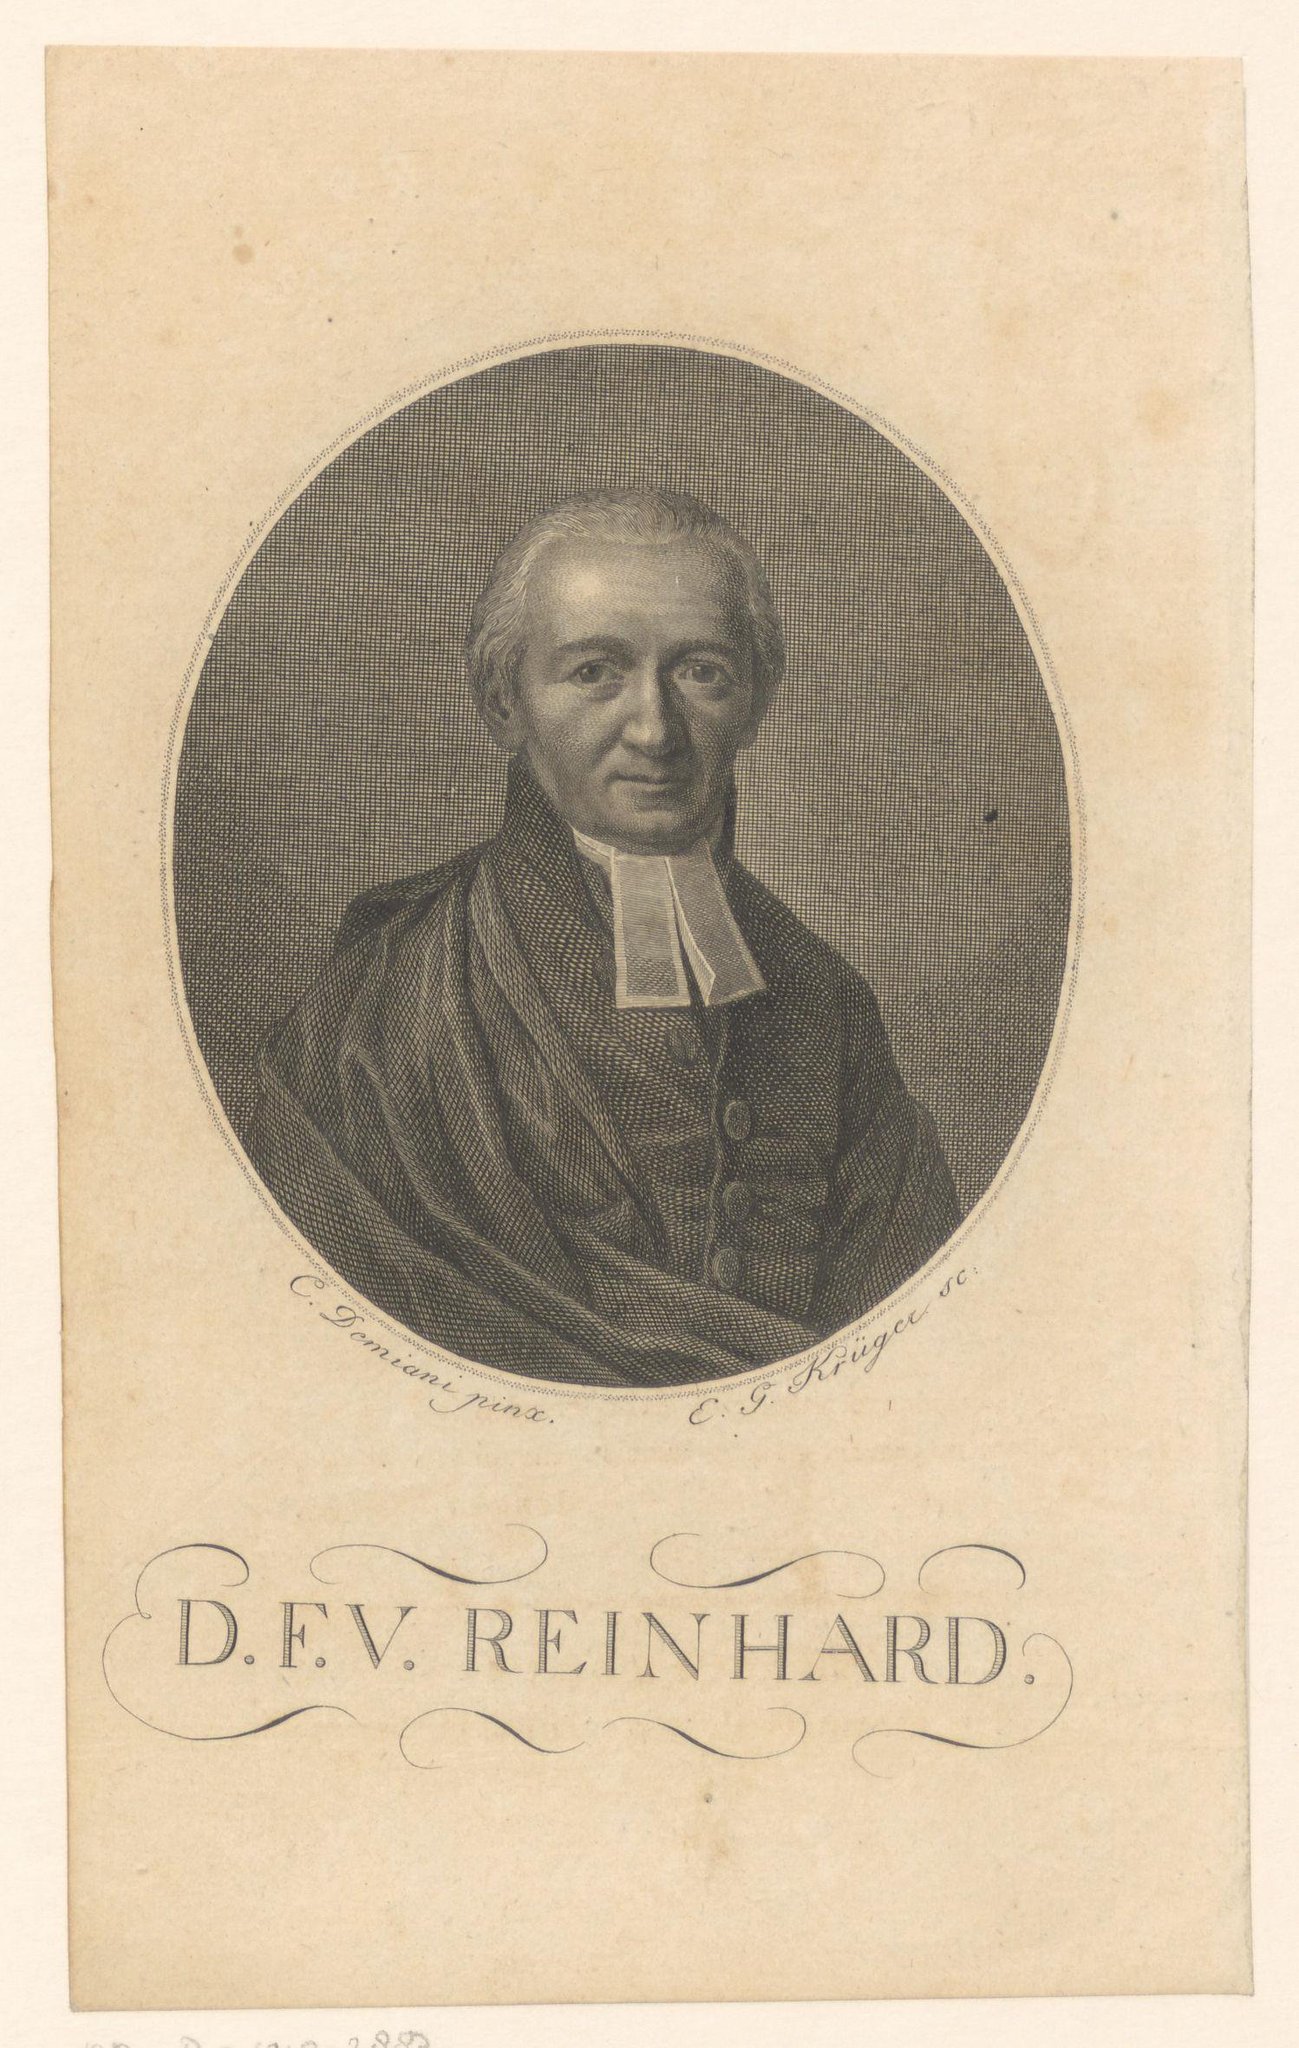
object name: print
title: Portret van Franz Volkmar Reinhard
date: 1766-1834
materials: paper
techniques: engraving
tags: historical persons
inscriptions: collector's mark: Lugt 2228